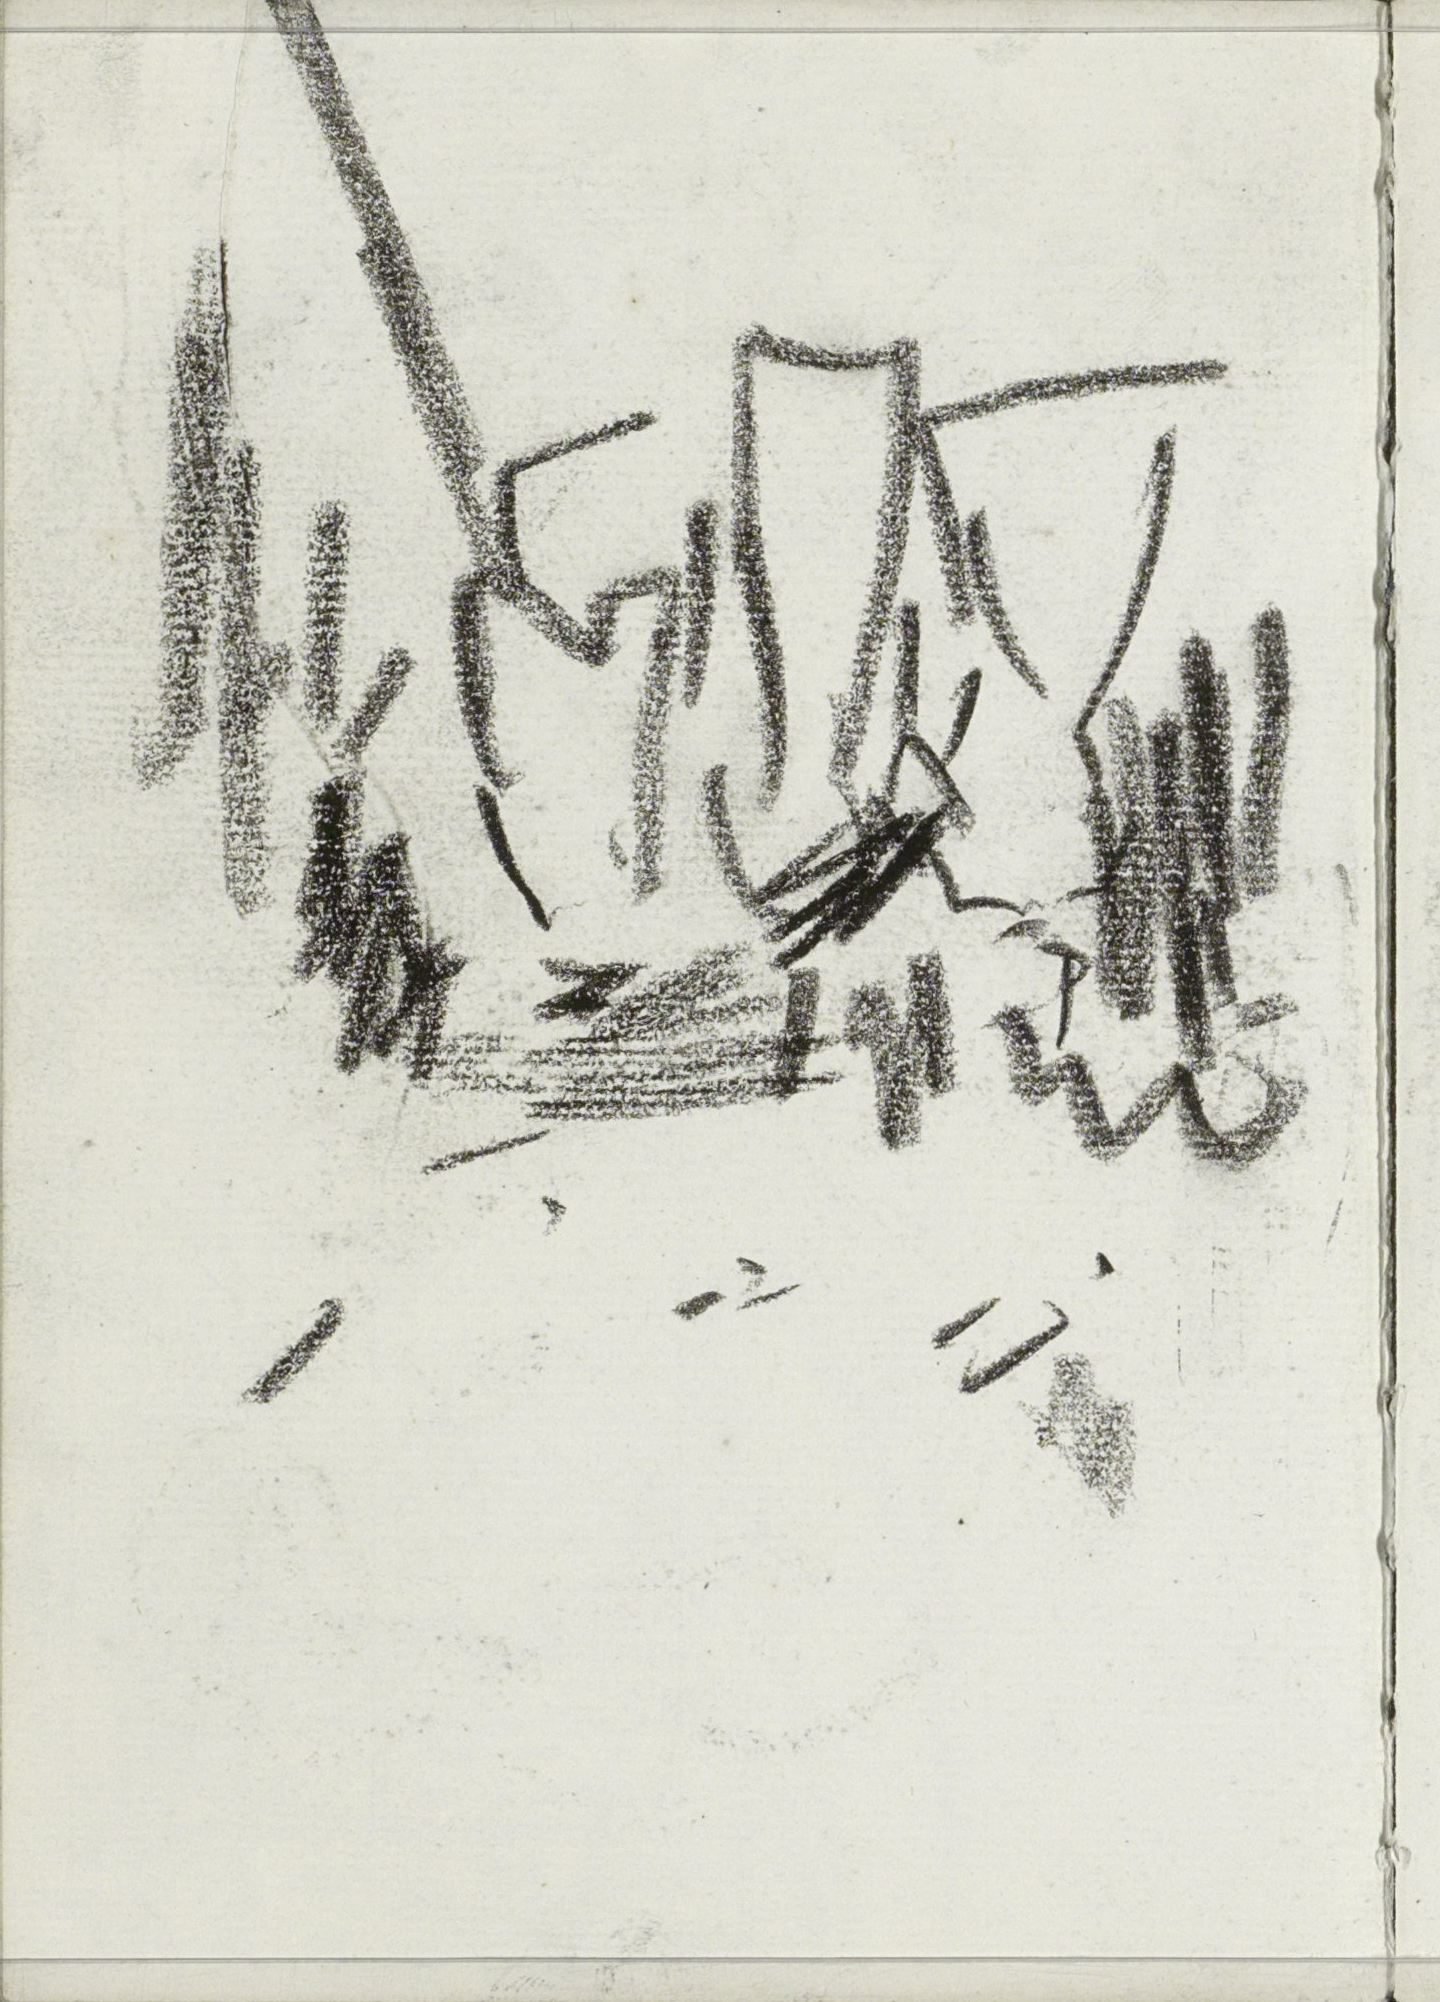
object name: sketchbook leaf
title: Vrouwen, mogelijk op straat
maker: isaac israels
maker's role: draughtsman, painter, print maker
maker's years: 1865-1934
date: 1886-1903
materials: chalk, paper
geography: amsterdam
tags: adult woman, street (+ city(-scape) with figures, staffage)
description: Pagina 40 uit schetsboek XXXVII met 52 pagina's.